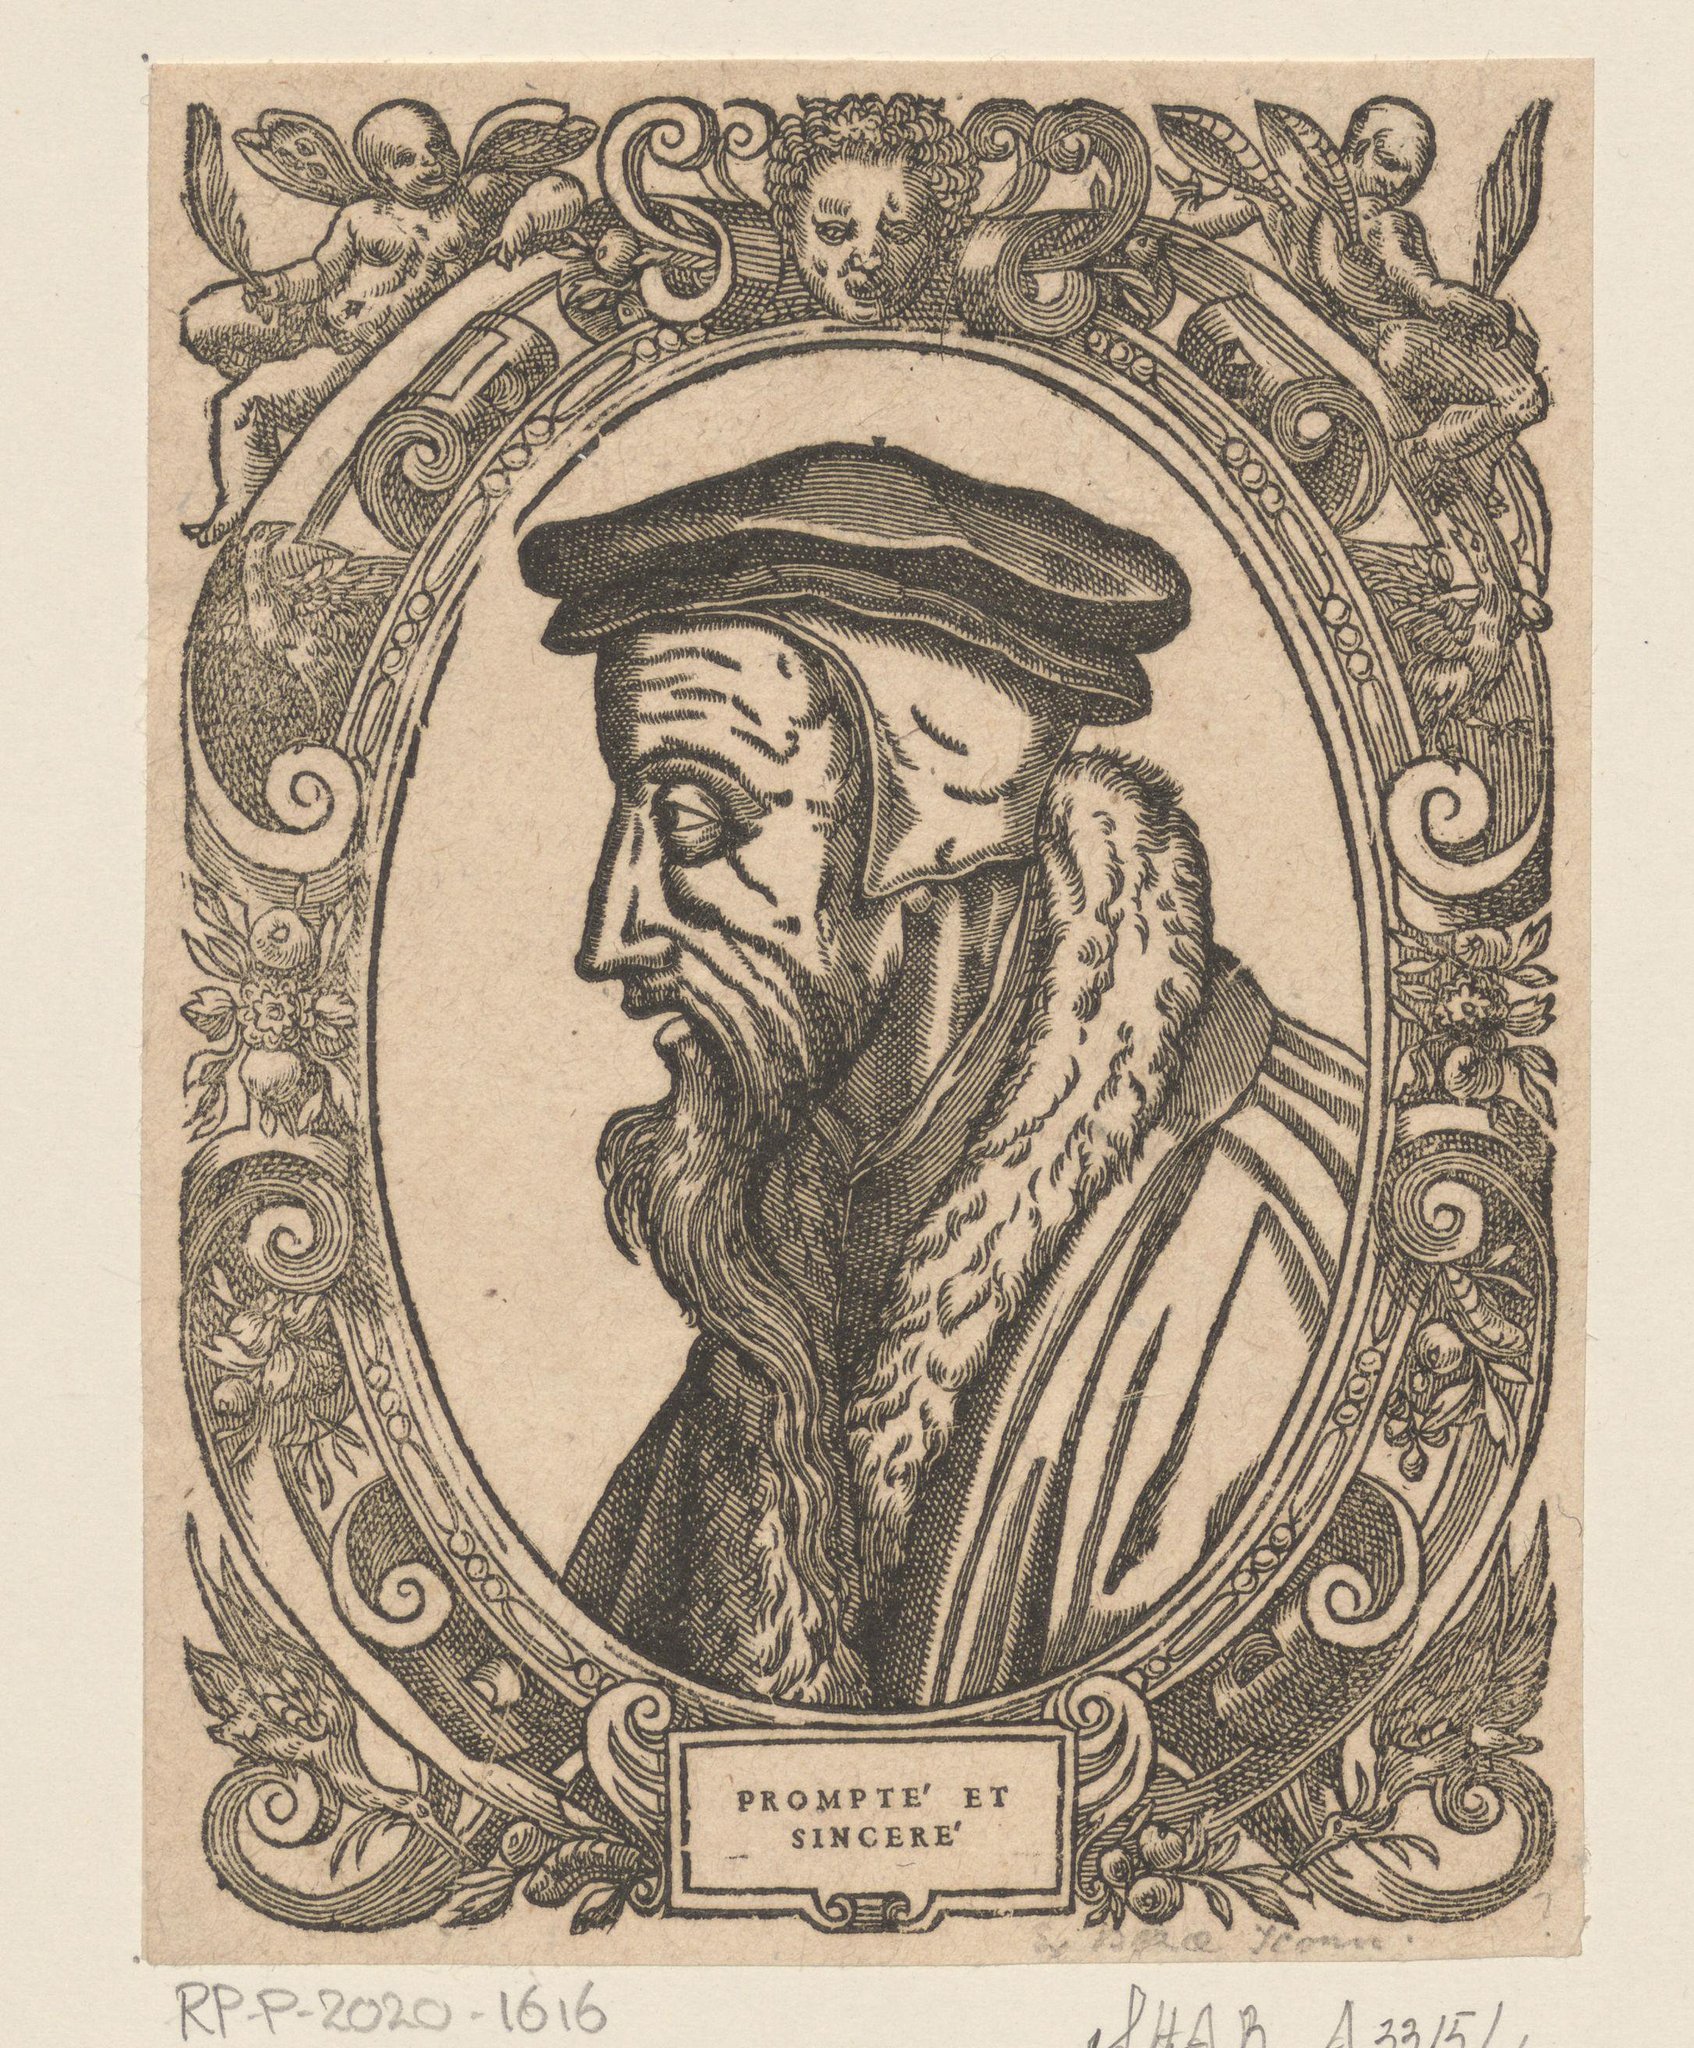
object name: print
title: Portret van Johannes Calvijn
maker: Anonymous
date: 1580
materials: paper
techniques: woodcut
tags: historical persons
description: Prent met ander onderschrift in: Bèze, Théodore de. Icones id est Verae imagines (...). Genève: Jean de Laon, 1580.